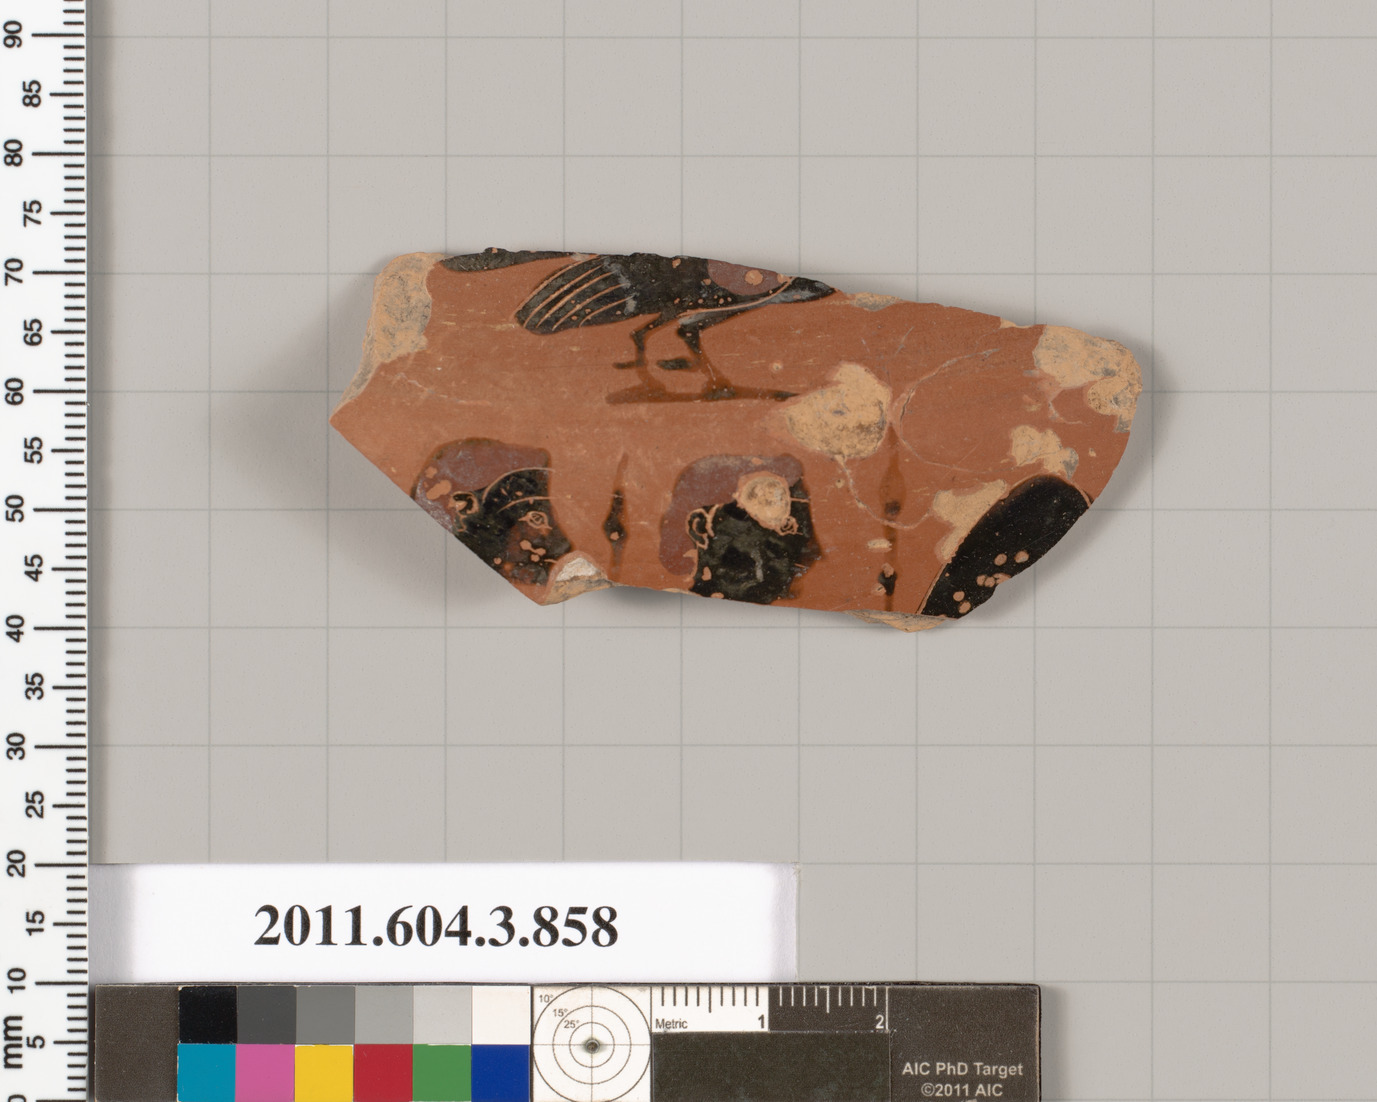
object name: lekythos fragment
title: Terracotta fragment of a lekythos (oil flask)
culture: greek, attic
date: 540-530 BCE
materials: terracotta